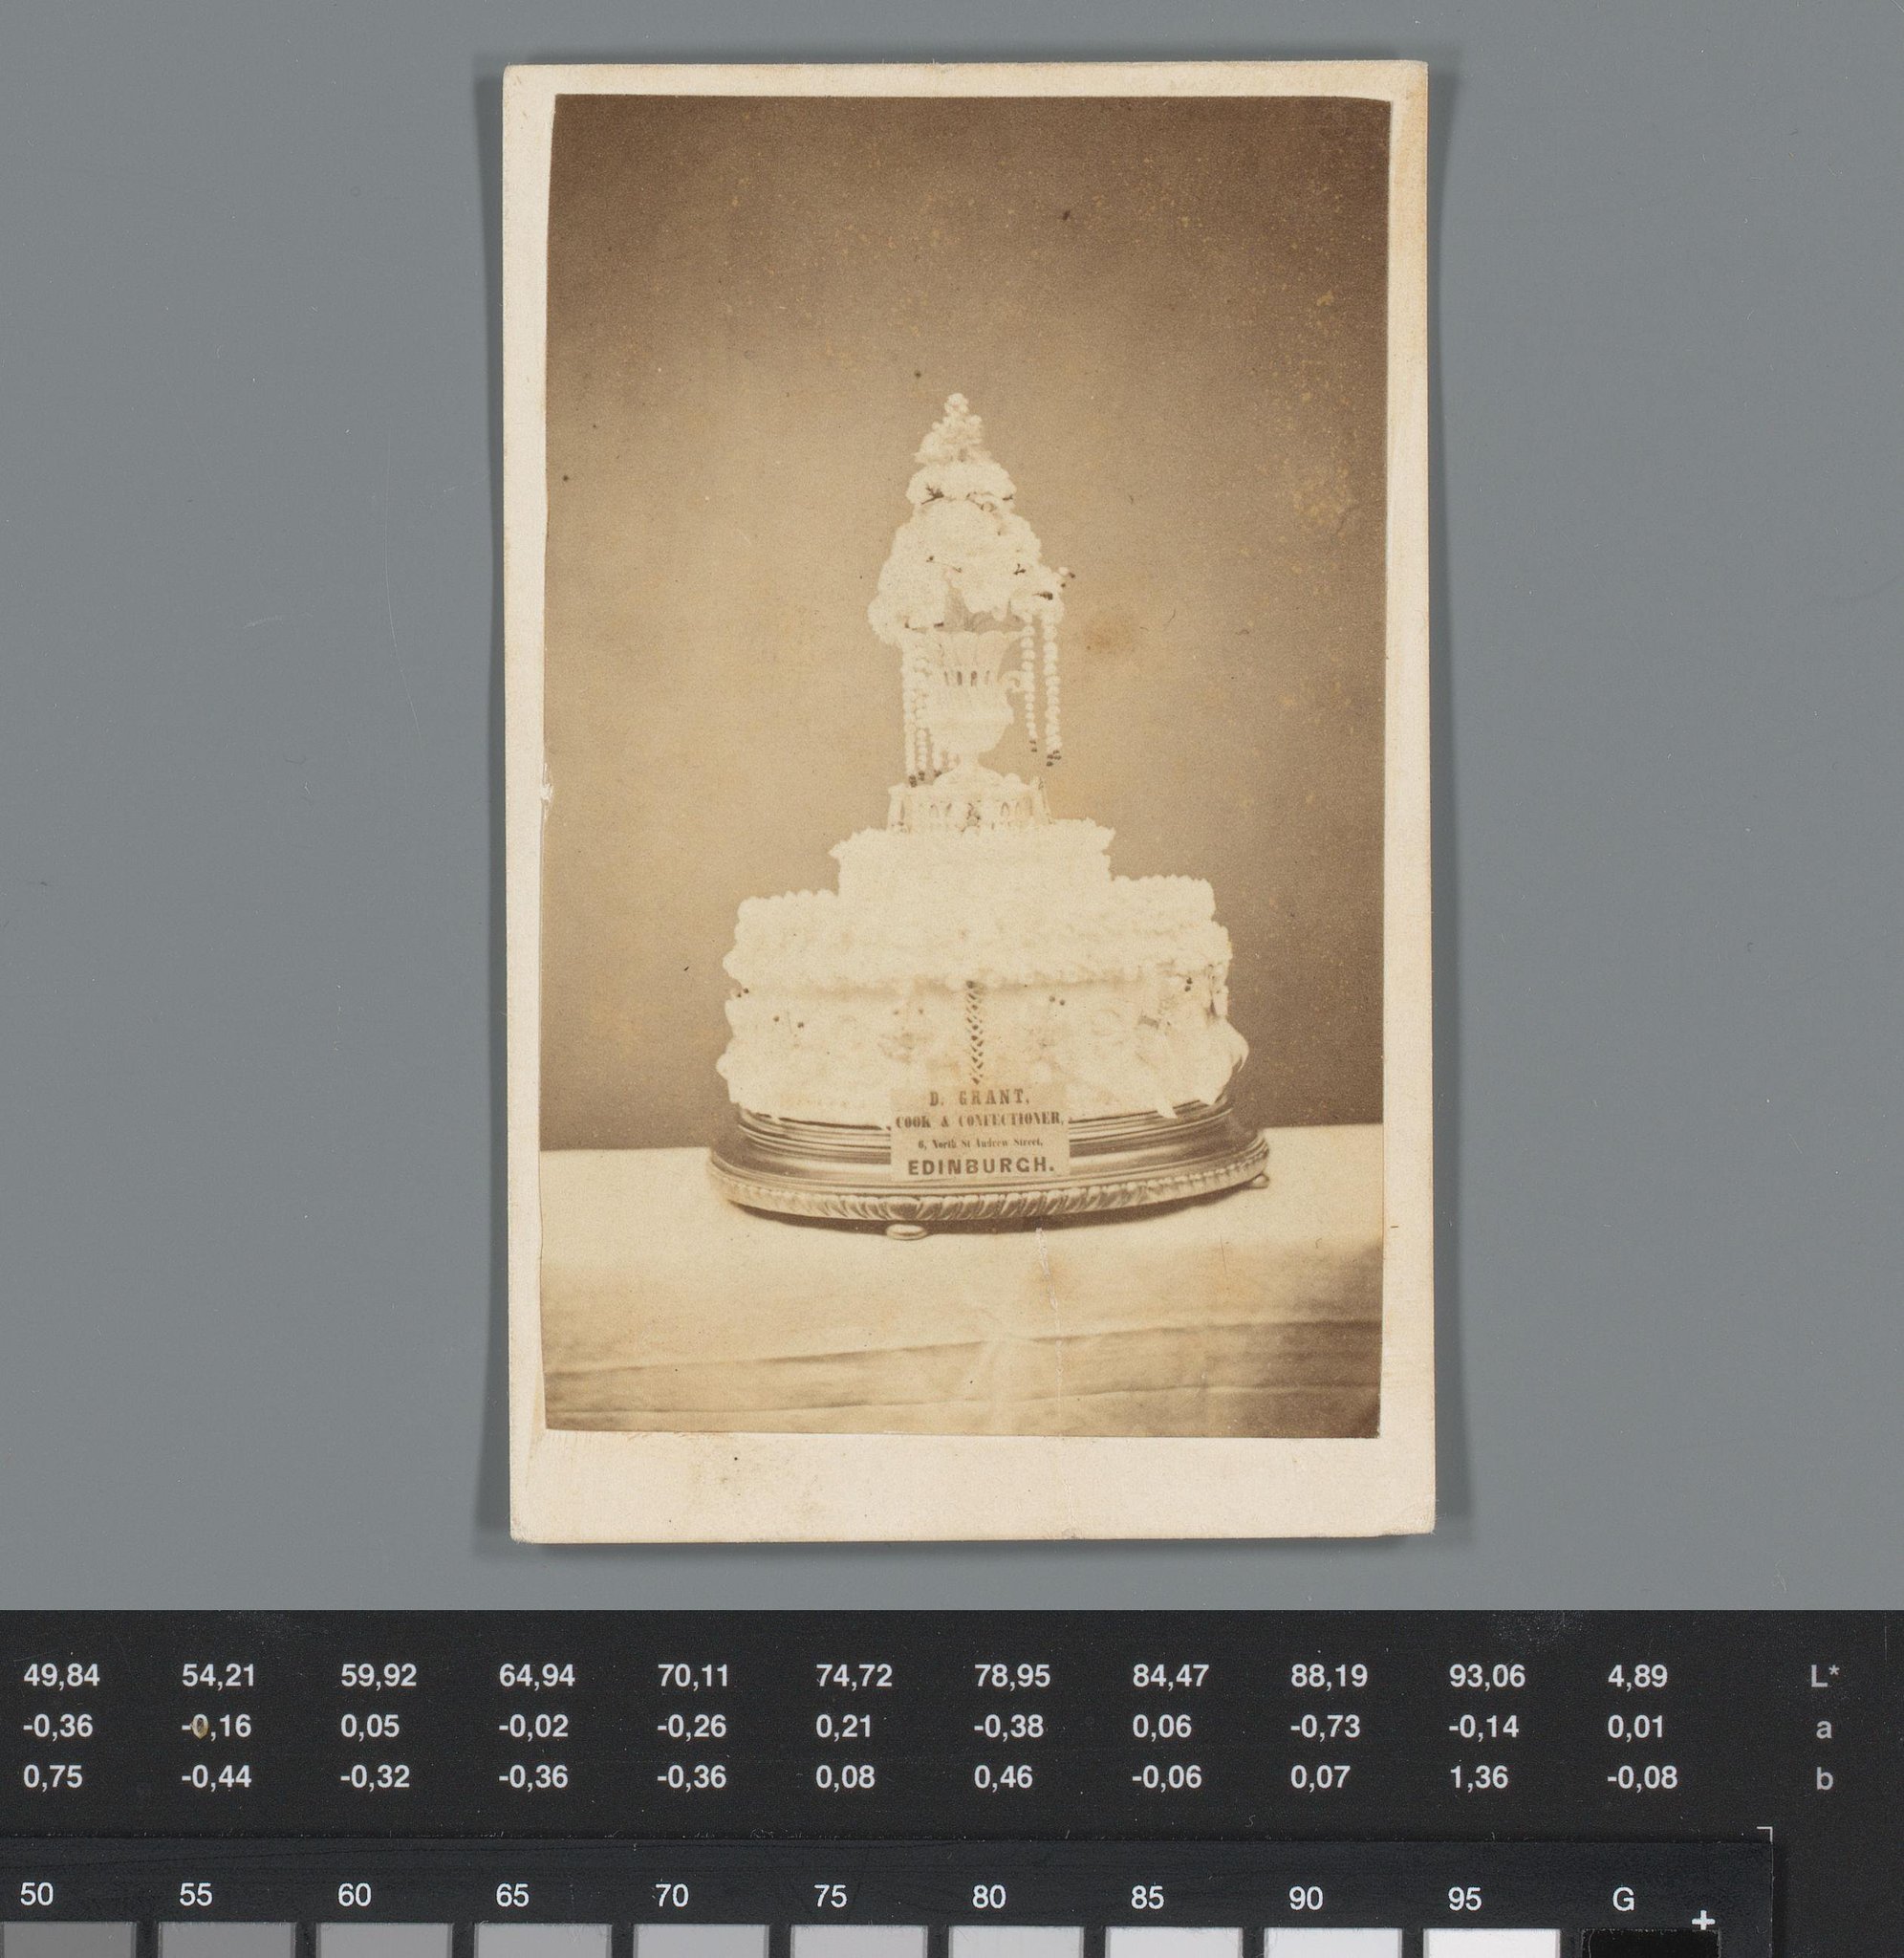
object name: carte de visite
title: Reclame voor banketbakker D. Grant te Edinburgh met gezicht op een bruidstaart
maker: Anonymous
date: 1850-1915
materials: cardboard, photographic support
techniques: albumen print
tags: advertising, wedding-cake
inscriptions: inscription: ‘D. GRANT. / COOK & CONFECTIONER. (...) EDINBURGH.’